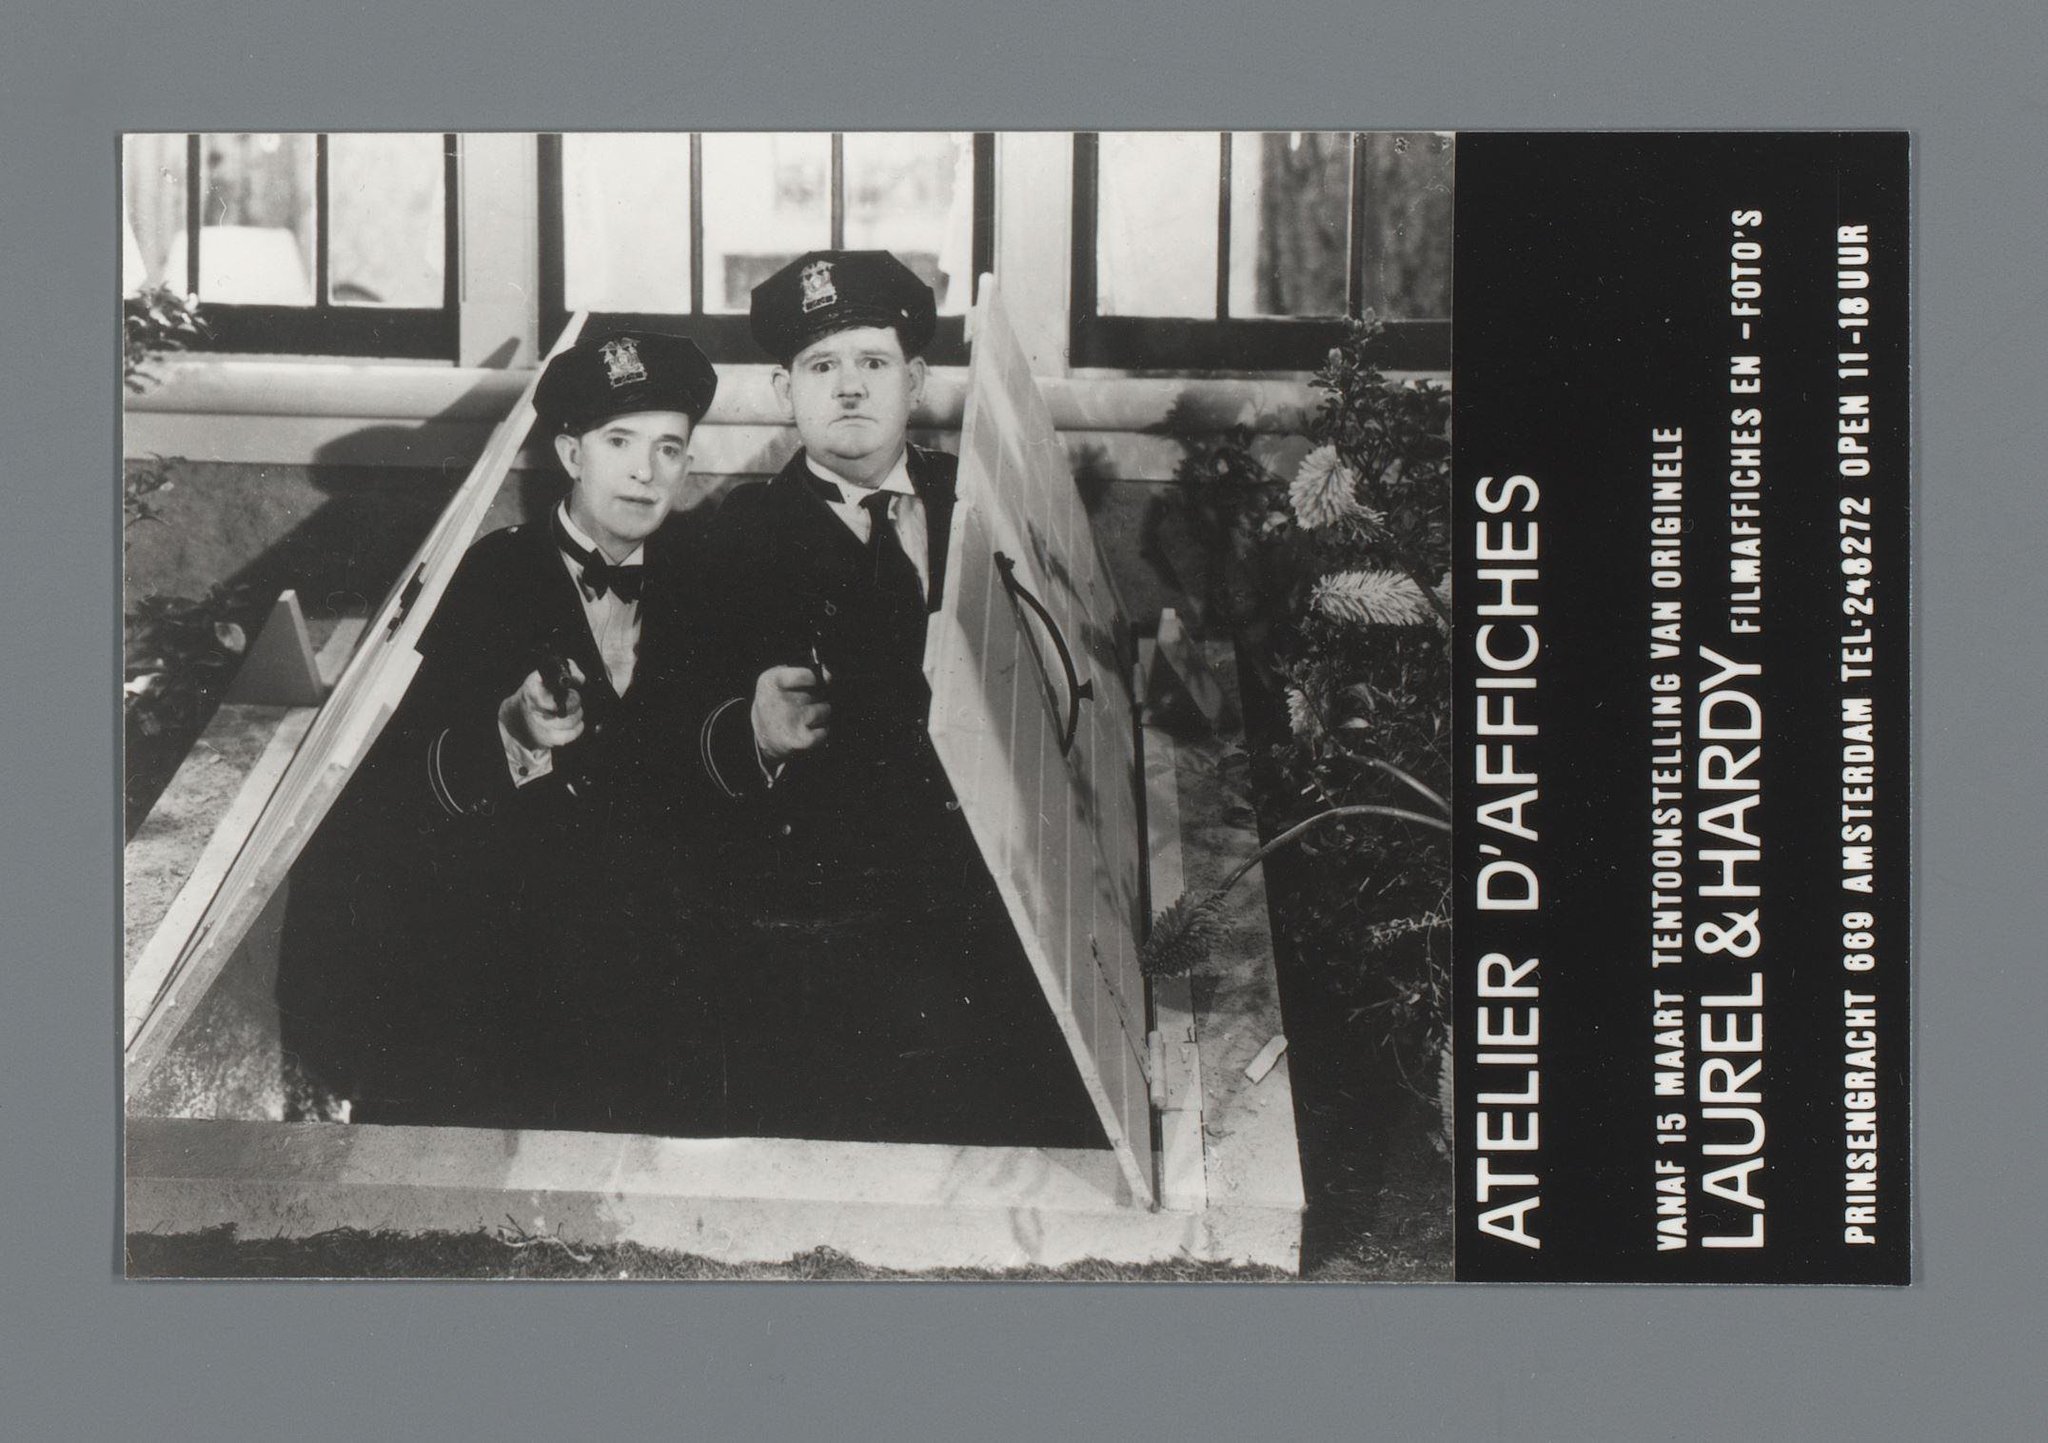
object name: advertisement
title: Laurel en Hardy als agenten staande in een kelderluik, reclame voor een tentoonstelling met filmaffiches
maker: Anonymous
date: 1980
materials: photographic support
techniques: gelatin silver print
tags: film actor (on the screen)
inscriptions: inscription: ‘ATELIER D'AFFICHES/ VANAF 15 MAART TENTOONSTELLING VAN ORIGINELE/ LAUREL & HARDY FILMAFFICHES EN -FOTO'S/ PRINSENGRACHT 669 AMSTERDAM TEL 248272 OPEN 11-18 UUR’